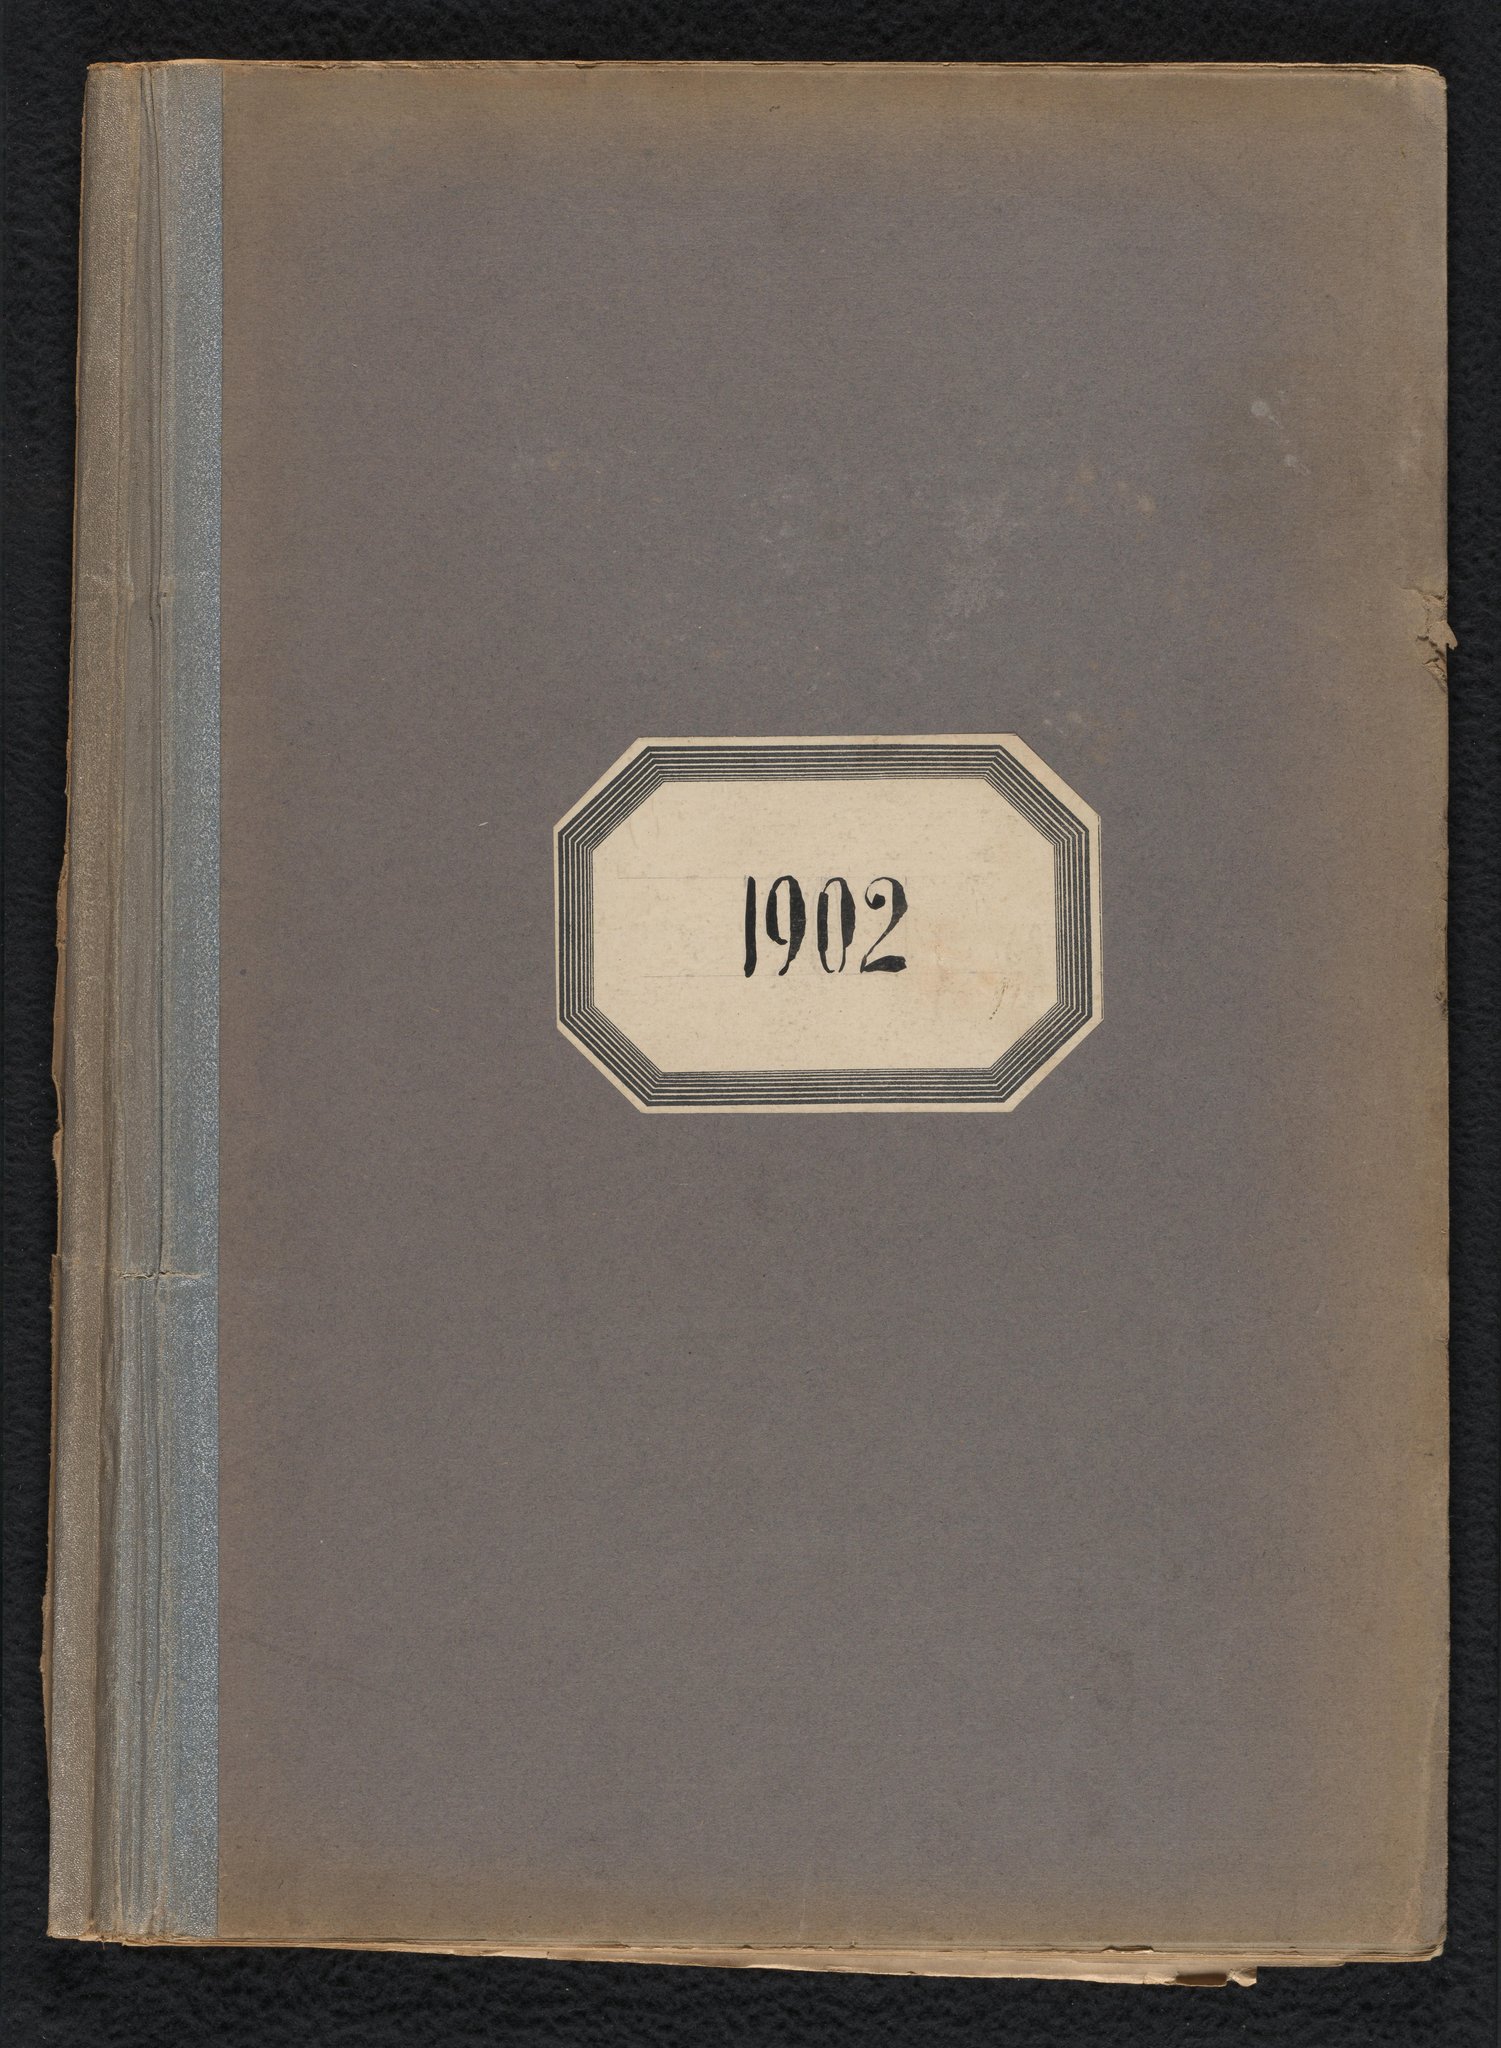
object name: cartoon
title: Spotprenten uit 'De Amsterdammer' van het jaar 1902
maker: johan braakensiek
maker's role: draughtsman, print maker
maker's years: 1858-1940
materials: paper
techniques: lithograph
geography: amsterdam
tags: political caricatures and satires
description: Bundel van 52 spotprenten van Braakensiek gepubliceerd als bijvoegsel bij 'De Amsterdammer' in het jaar 1902. Bundel geplakt in slappe omslag van grijsgroen karton met handgeschreven etiket '1902'.